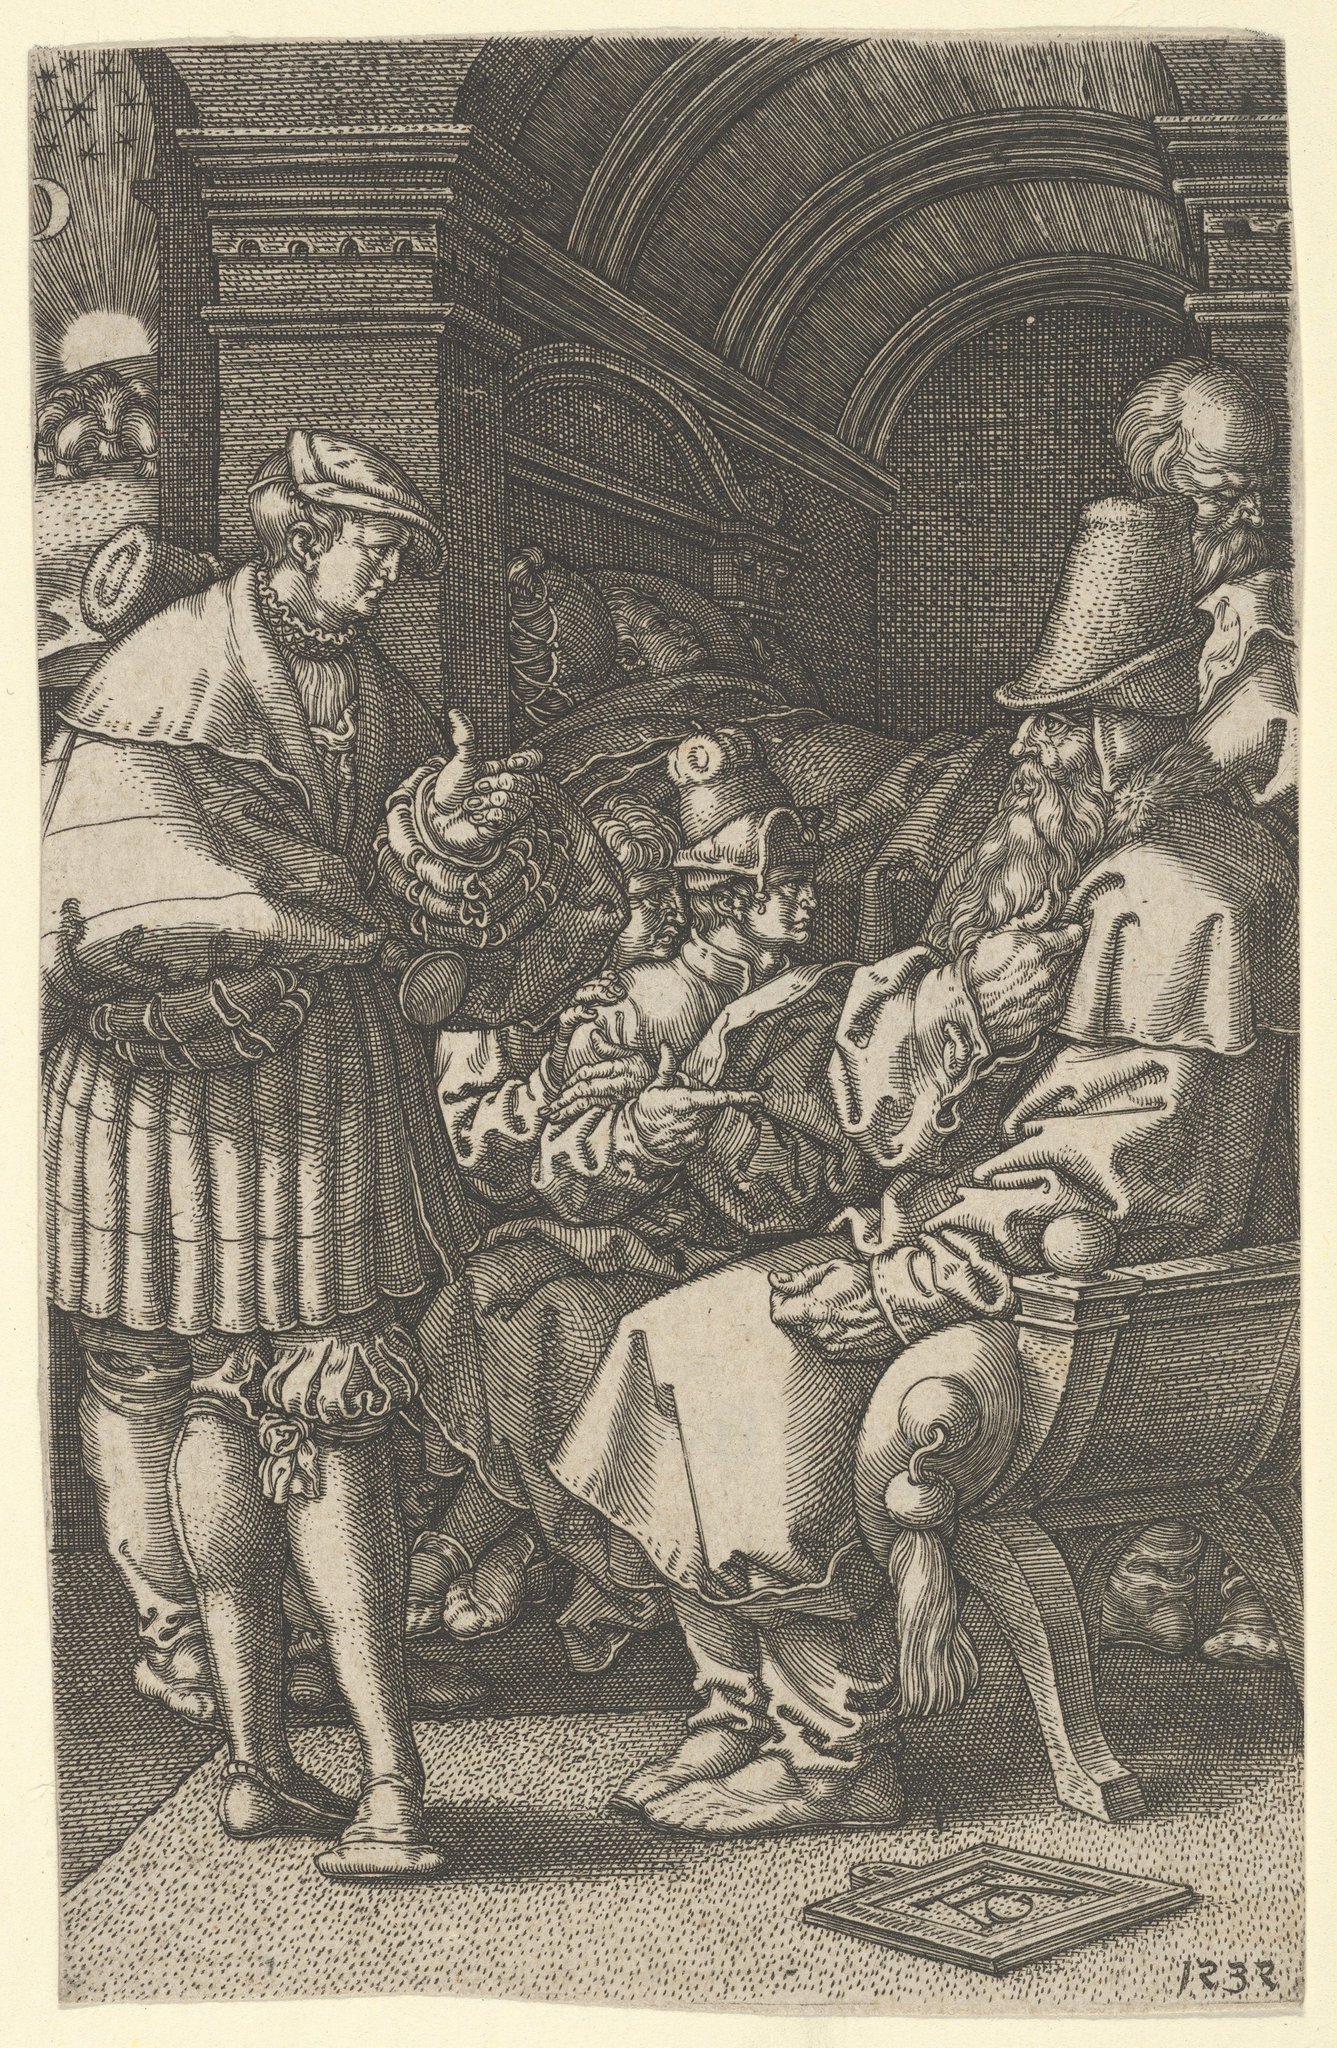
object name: print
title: Joseph Explaining His Dreams to Jacob, from "The Story of Joseph"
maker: heinrich aldegrever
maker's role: artist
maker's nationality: german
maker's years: 1502-1561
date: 1532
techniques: engraving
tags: men,beds